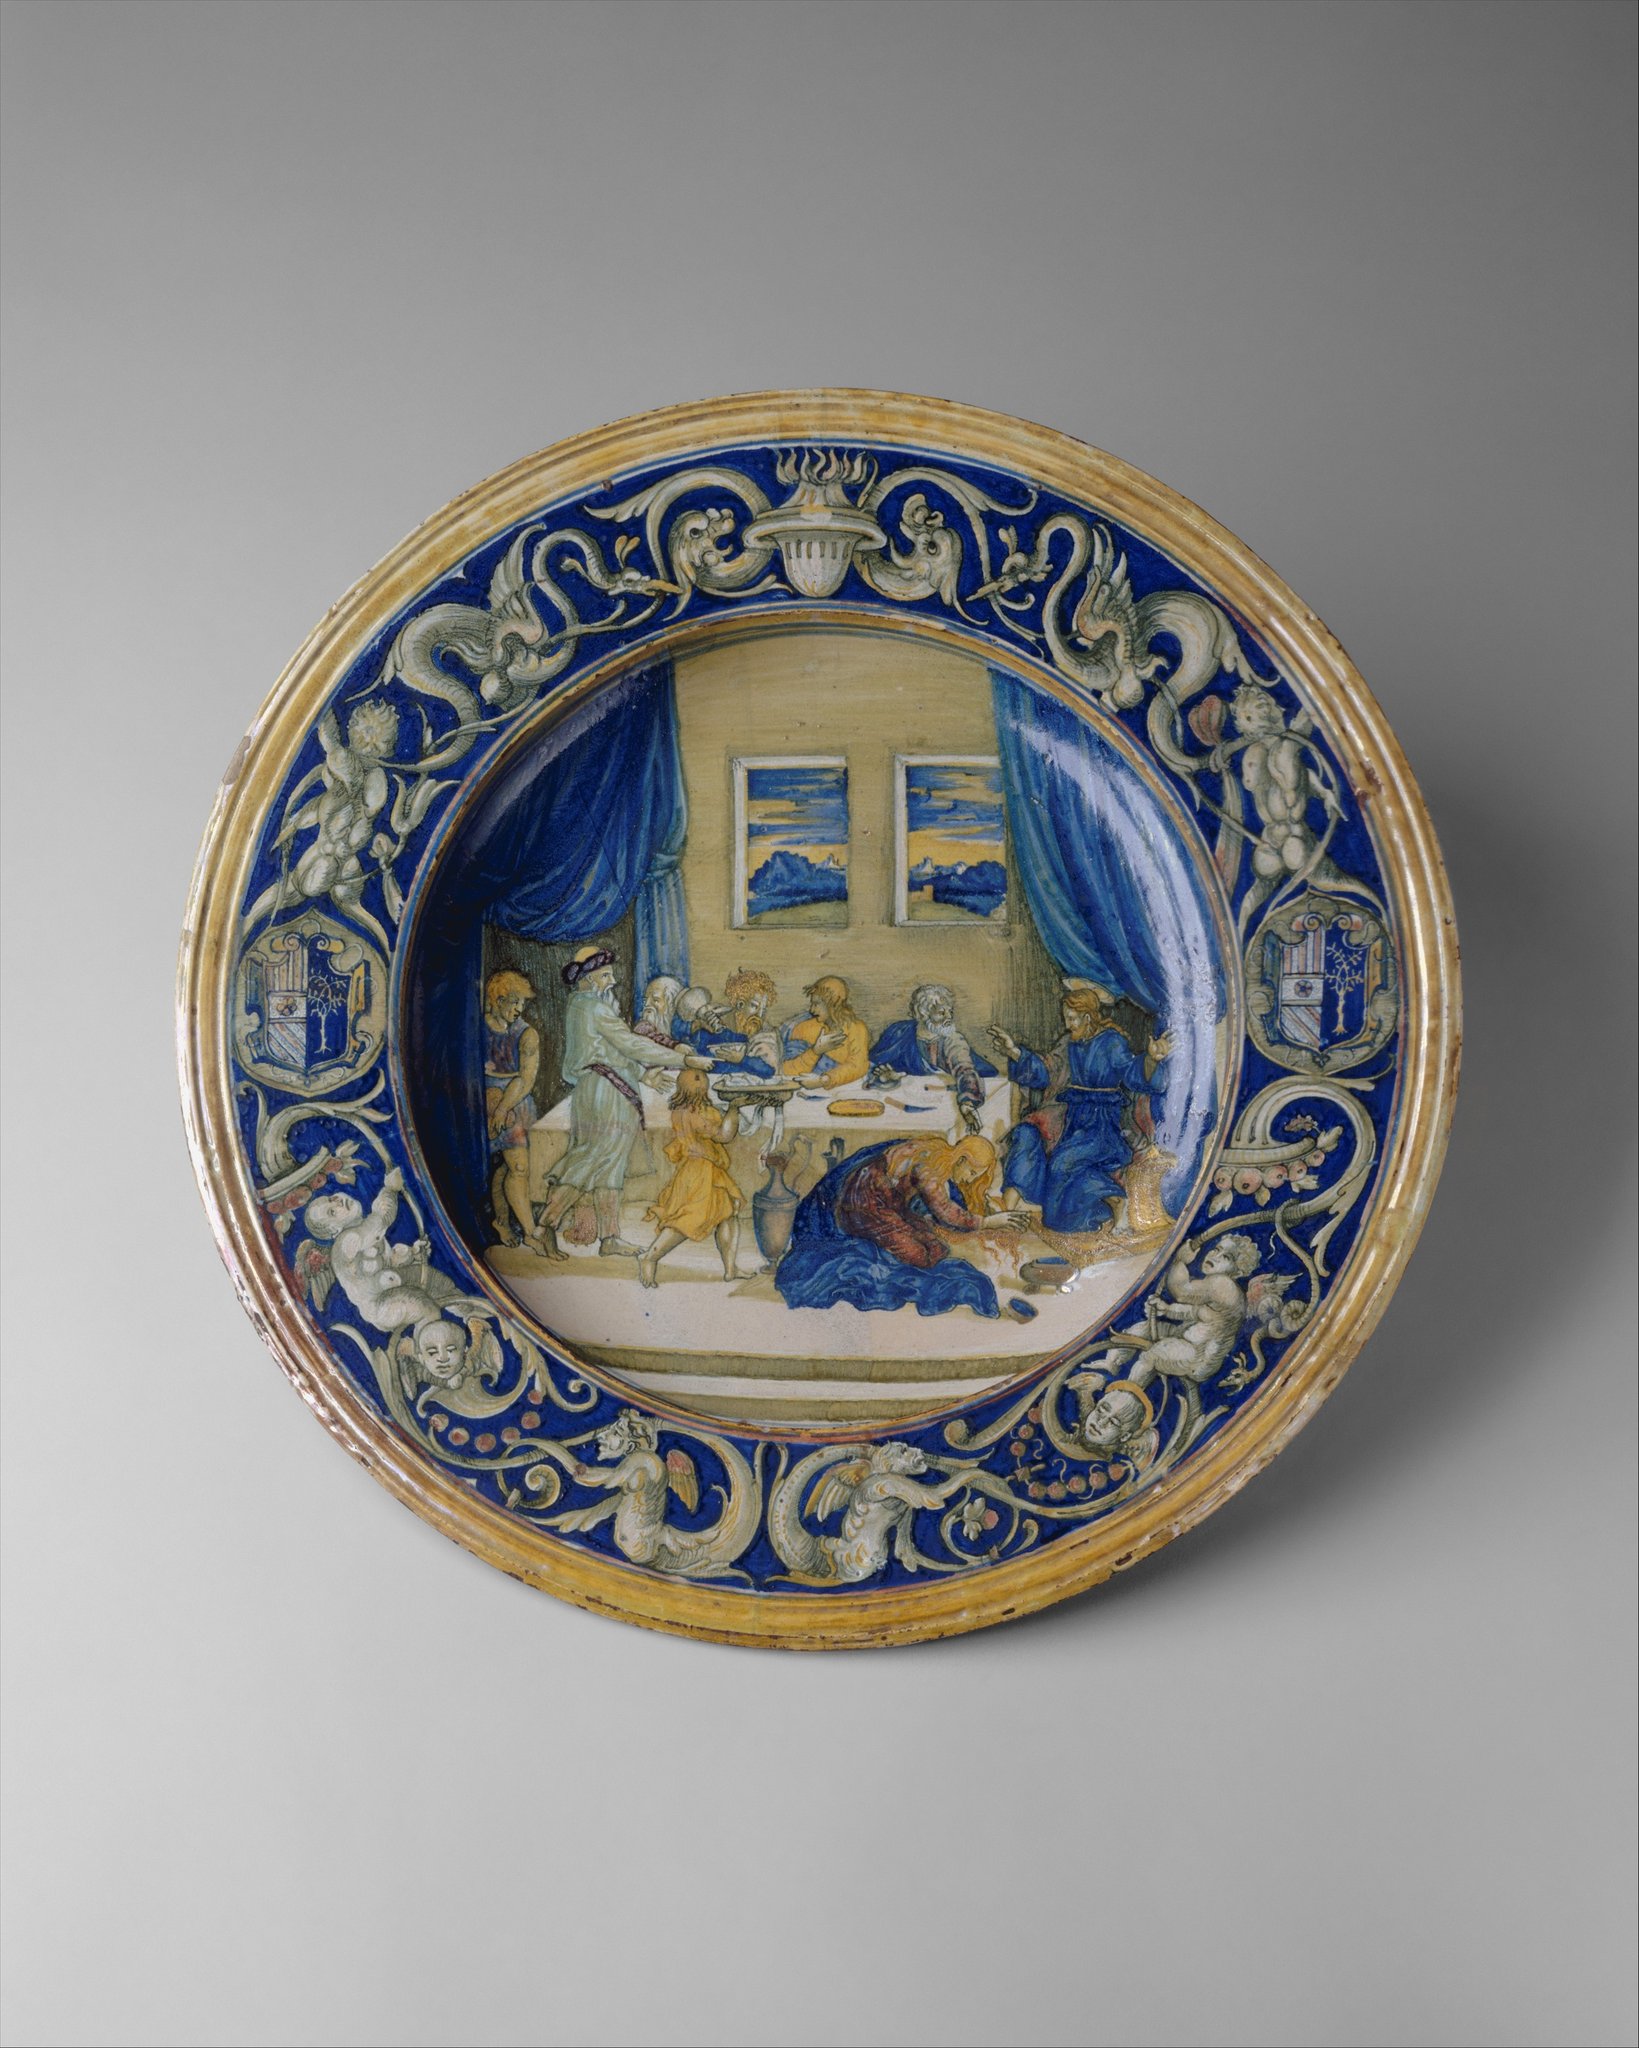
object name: dish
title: Armorial dish: Supper at the House of Simon the Pharisee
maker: maestro giorgio andreoli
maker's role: artist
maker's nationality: italian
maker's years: 1500-1550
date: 1528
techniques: maiolica, glazing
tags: men,christ,mary magdalene,dining,coat of arms